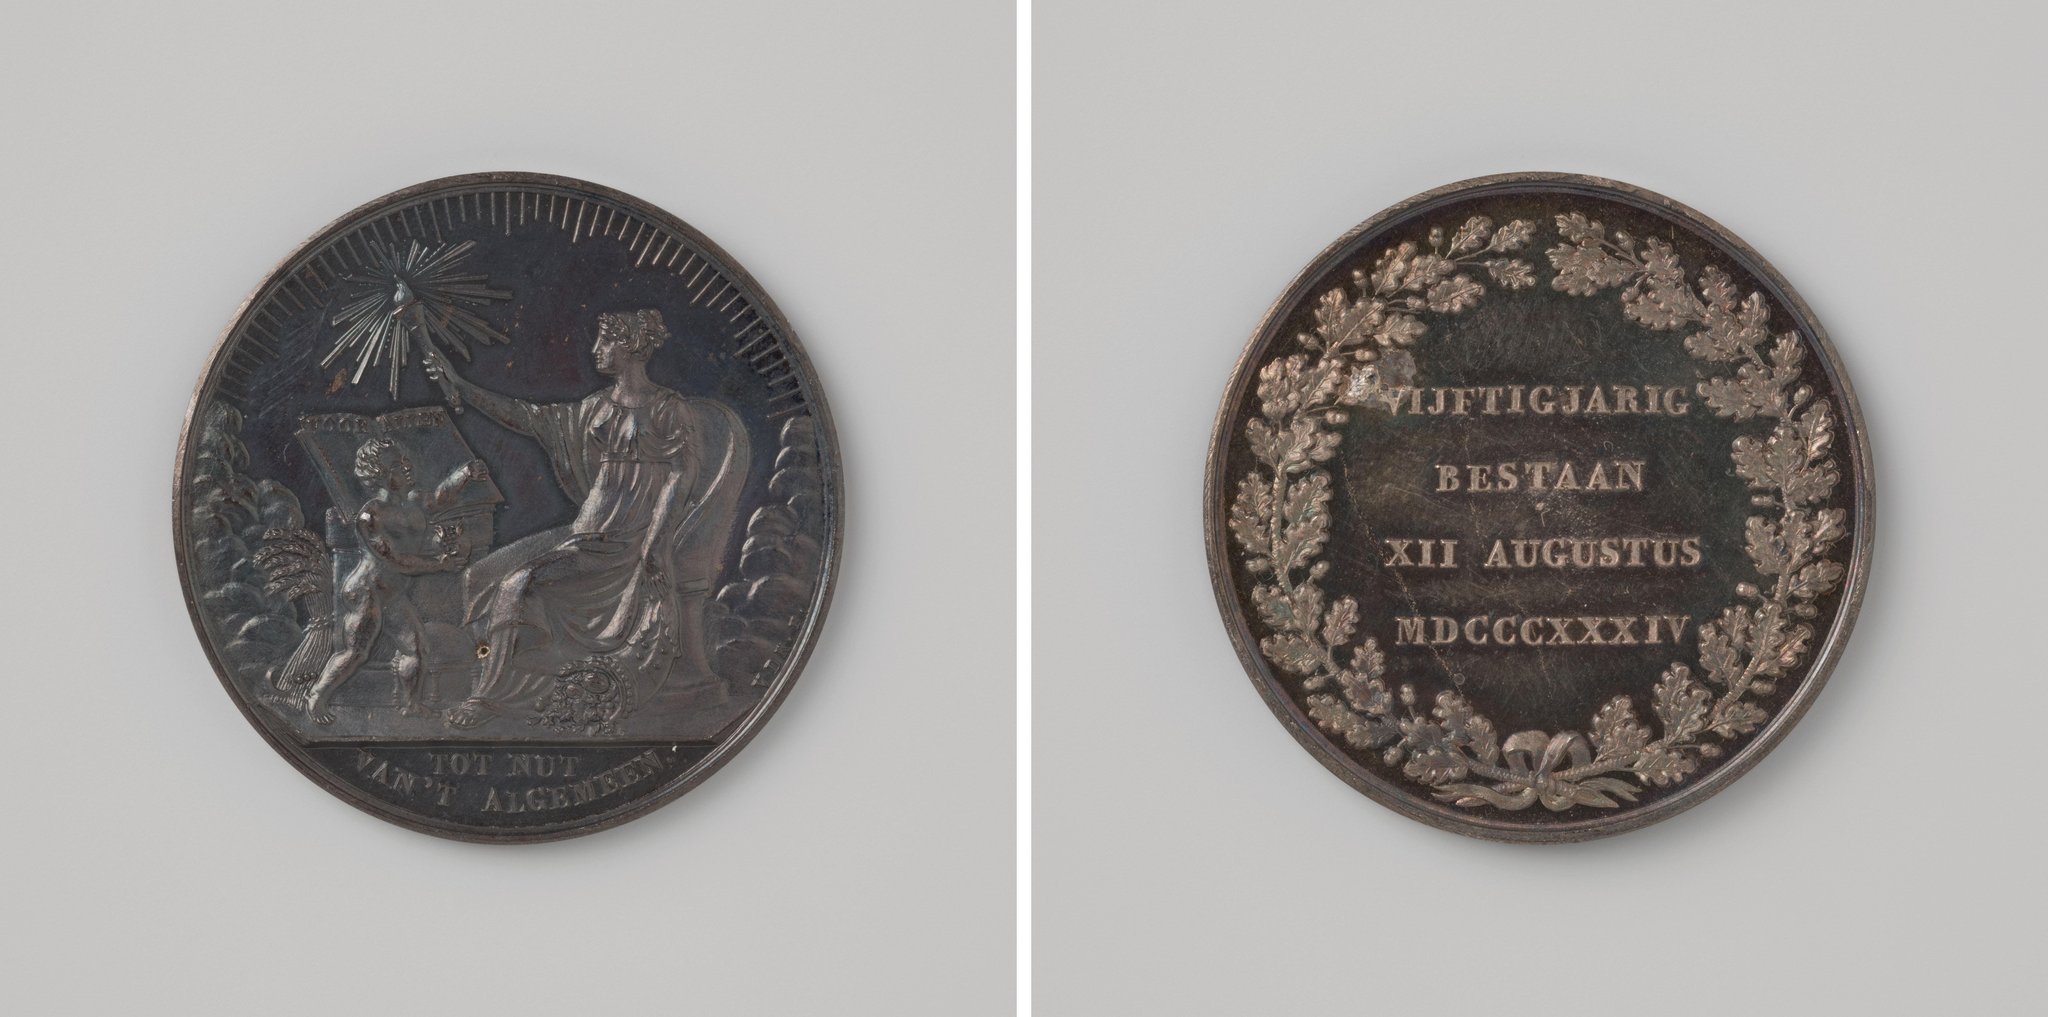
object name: history medal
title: Vijftigjarig bestaan van de Maatschappij tot Nut van 't Algemeen 1834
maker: david van der kellen (1804-1879)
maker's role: die cutter, draughtsman, print maker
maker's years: 1804-1879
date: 1834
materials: silver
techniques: striking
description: Zilveren penning, op de voorzijde de Maatschappij als getroonde vrouw met hoorn des overvloeds en fakkel bij een altaar, waarop een open boek beschreven VOOR ALLEN, waarnaast een knaapje met een open granaatappel, alles te midden van wolken en vanaf de penningrand beschenen door vijftig stralen, met afsnedetekst, op de keerzijde vier regels tekst tussen samengestrikte eikentakken.